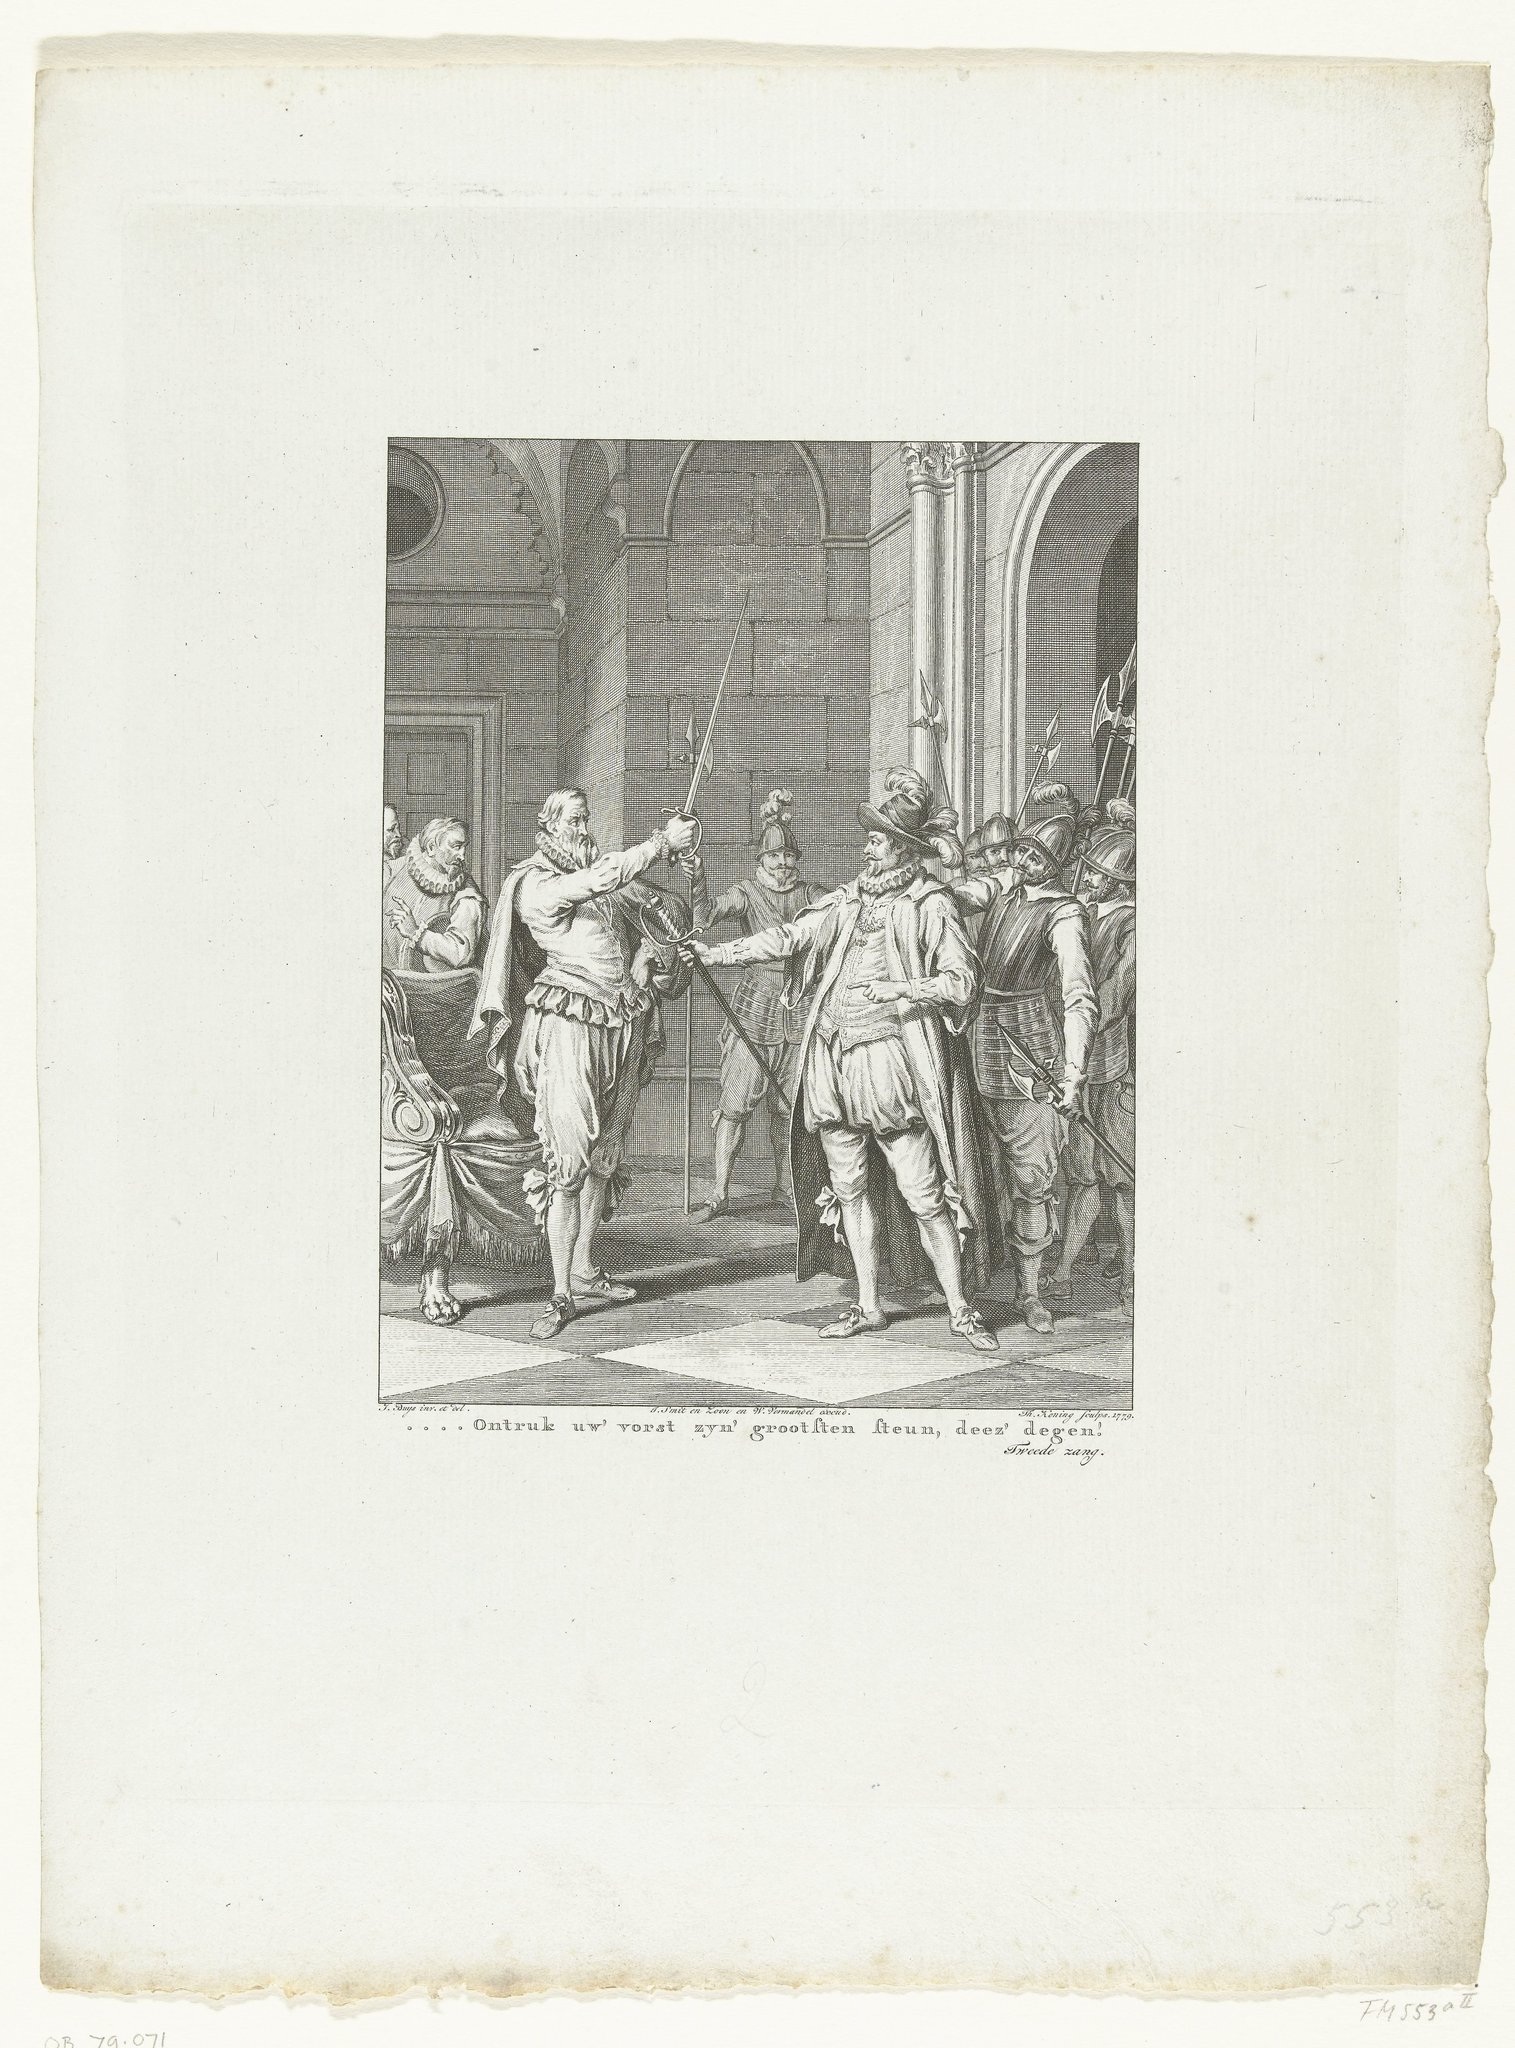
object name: print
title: Taferelen uit het leven van prins Willem I, 1568-1584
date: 1779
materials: paper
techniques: etching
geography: northern netherlands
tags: fernando álvarez de toledo (3rd duke of alba), brussels, earl, law and jurisprudence (+ arrest)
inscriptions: date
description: Illustratie voor: J. Nomsz, Willem de eerste, of de grondlegging der Nederlandsche vryheid. : In vier en twintig zangen, Erven van David Klippink, Amsterdam 1779. Staat met de letter.